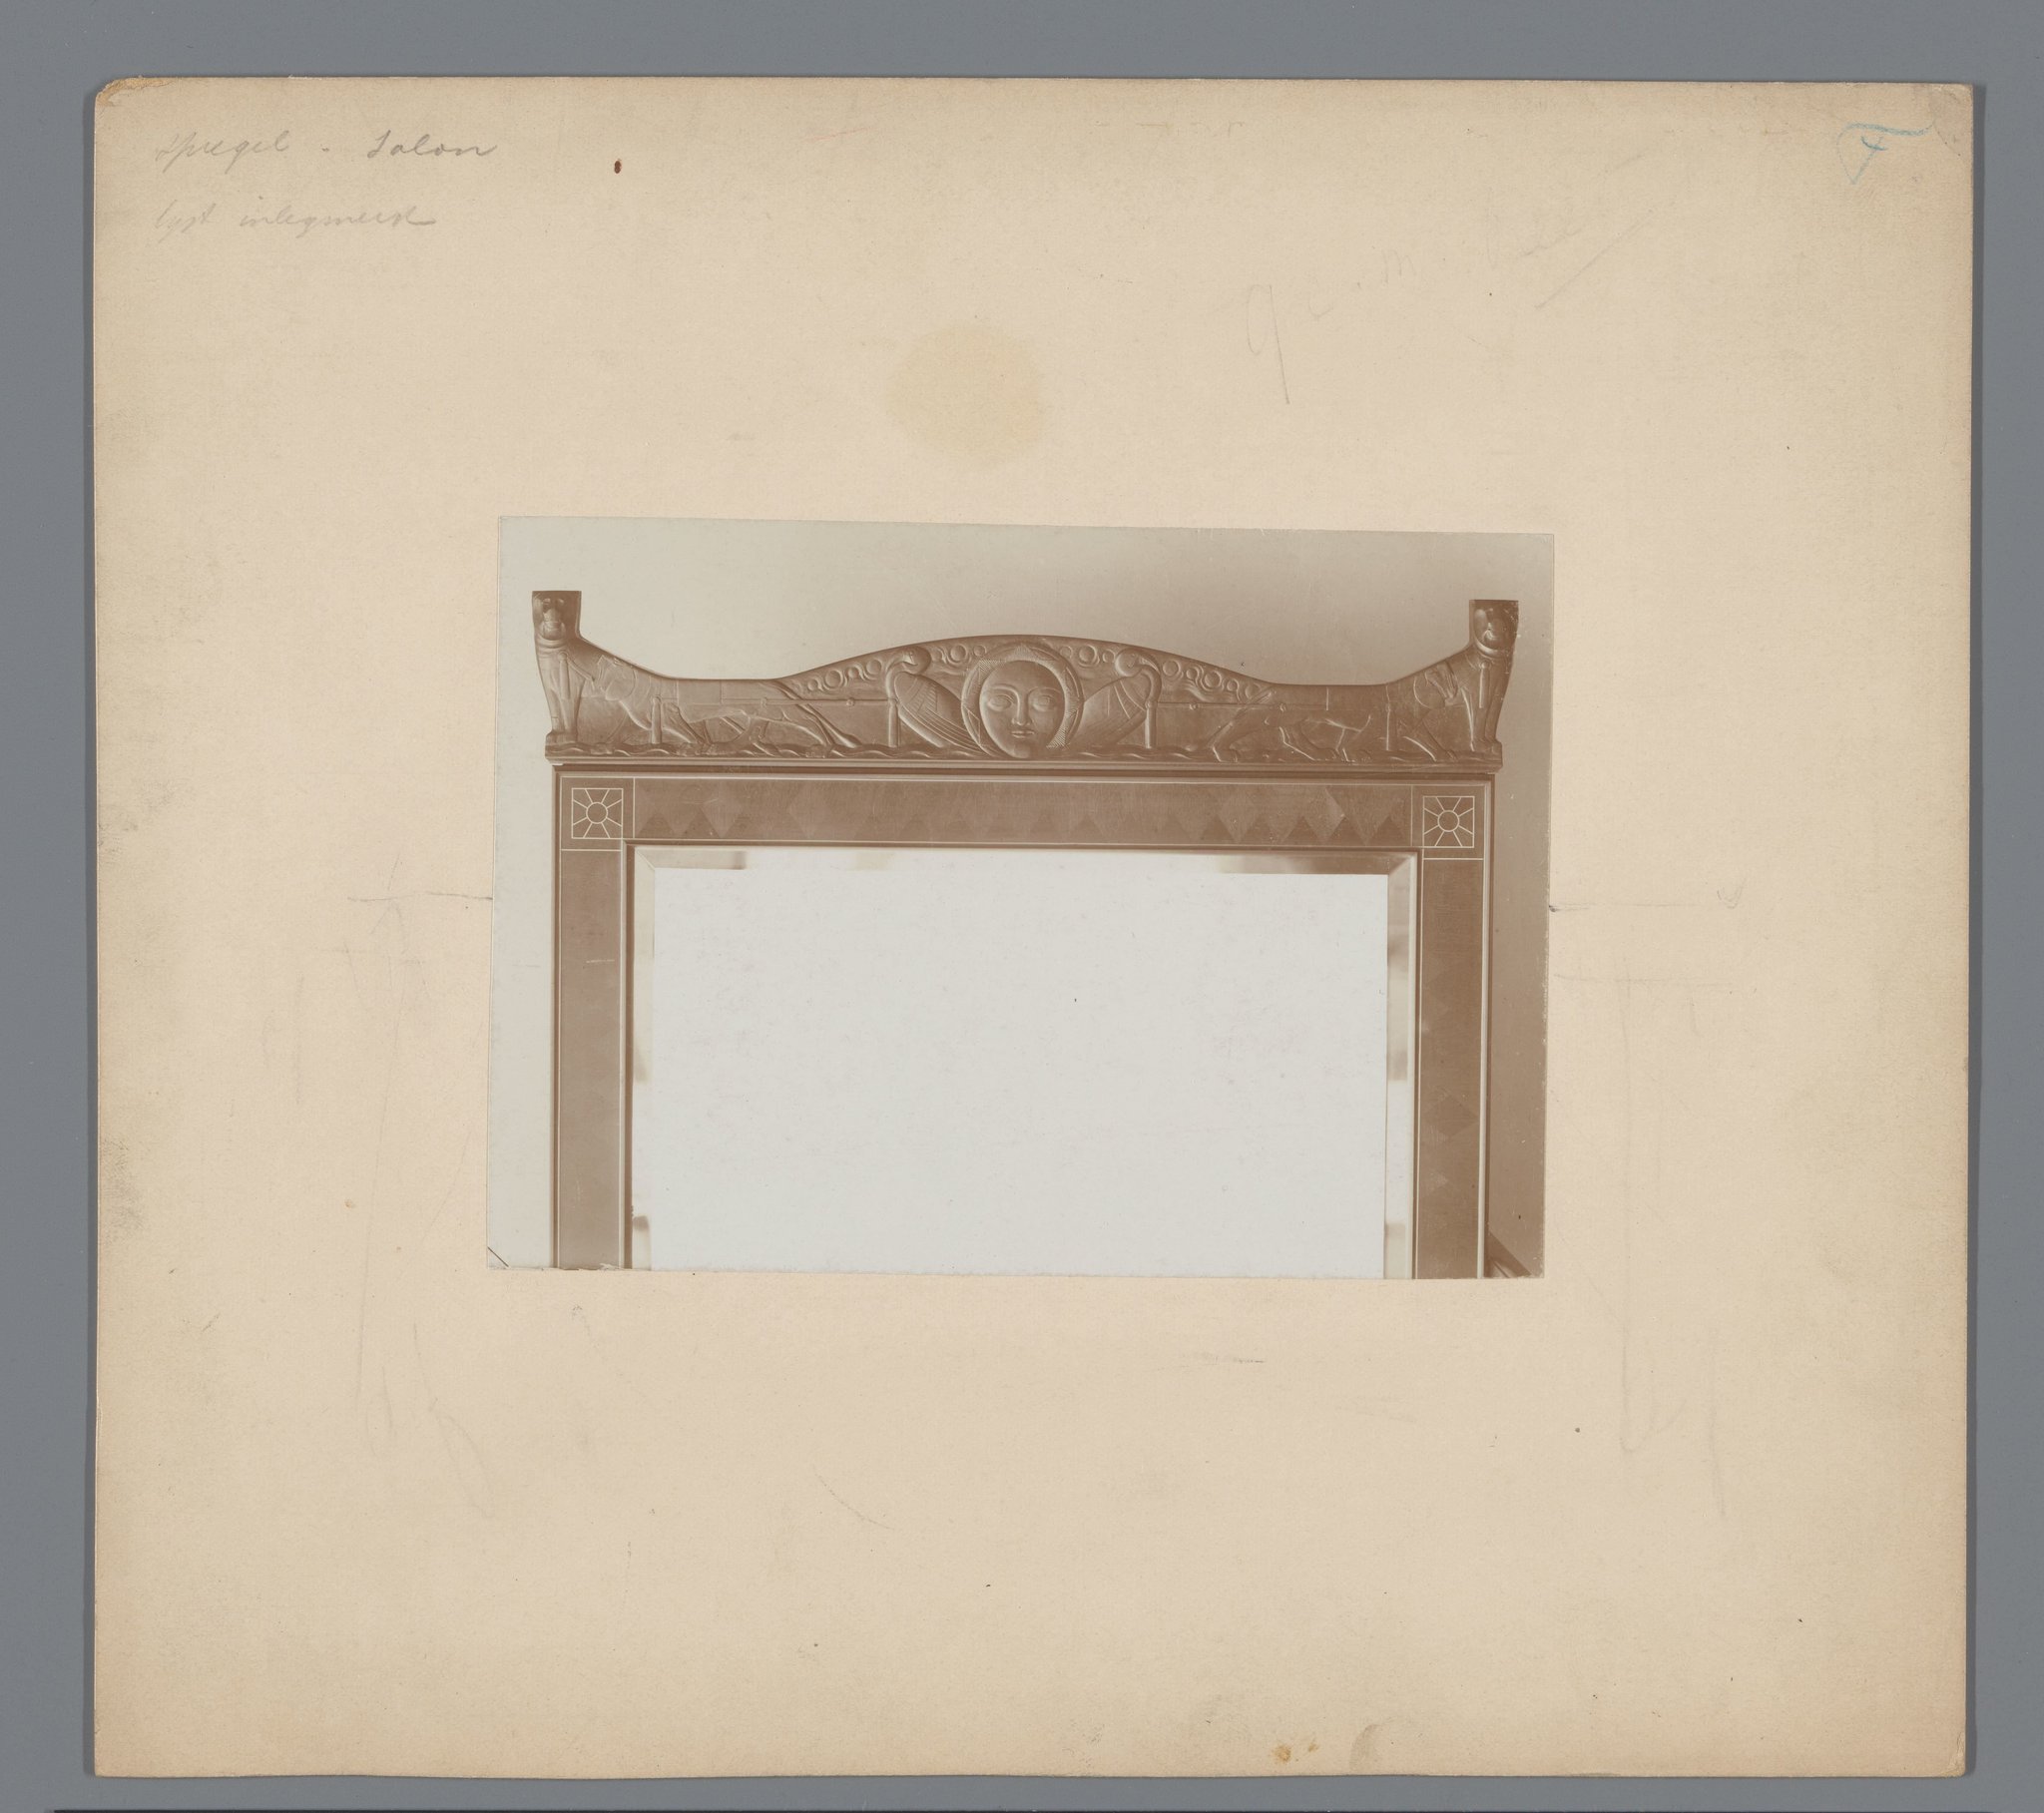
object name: photograph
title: Detail van een spiegel naar ontwerp van Mathieu Lauweriks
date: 1910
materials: cardboard, photographic support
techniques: collodion silver print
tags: mirror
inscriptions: annotation: ‘spiegel - salon/ lijst inlegwerk’, annotation: ‘F’, annotation: ‘B.’